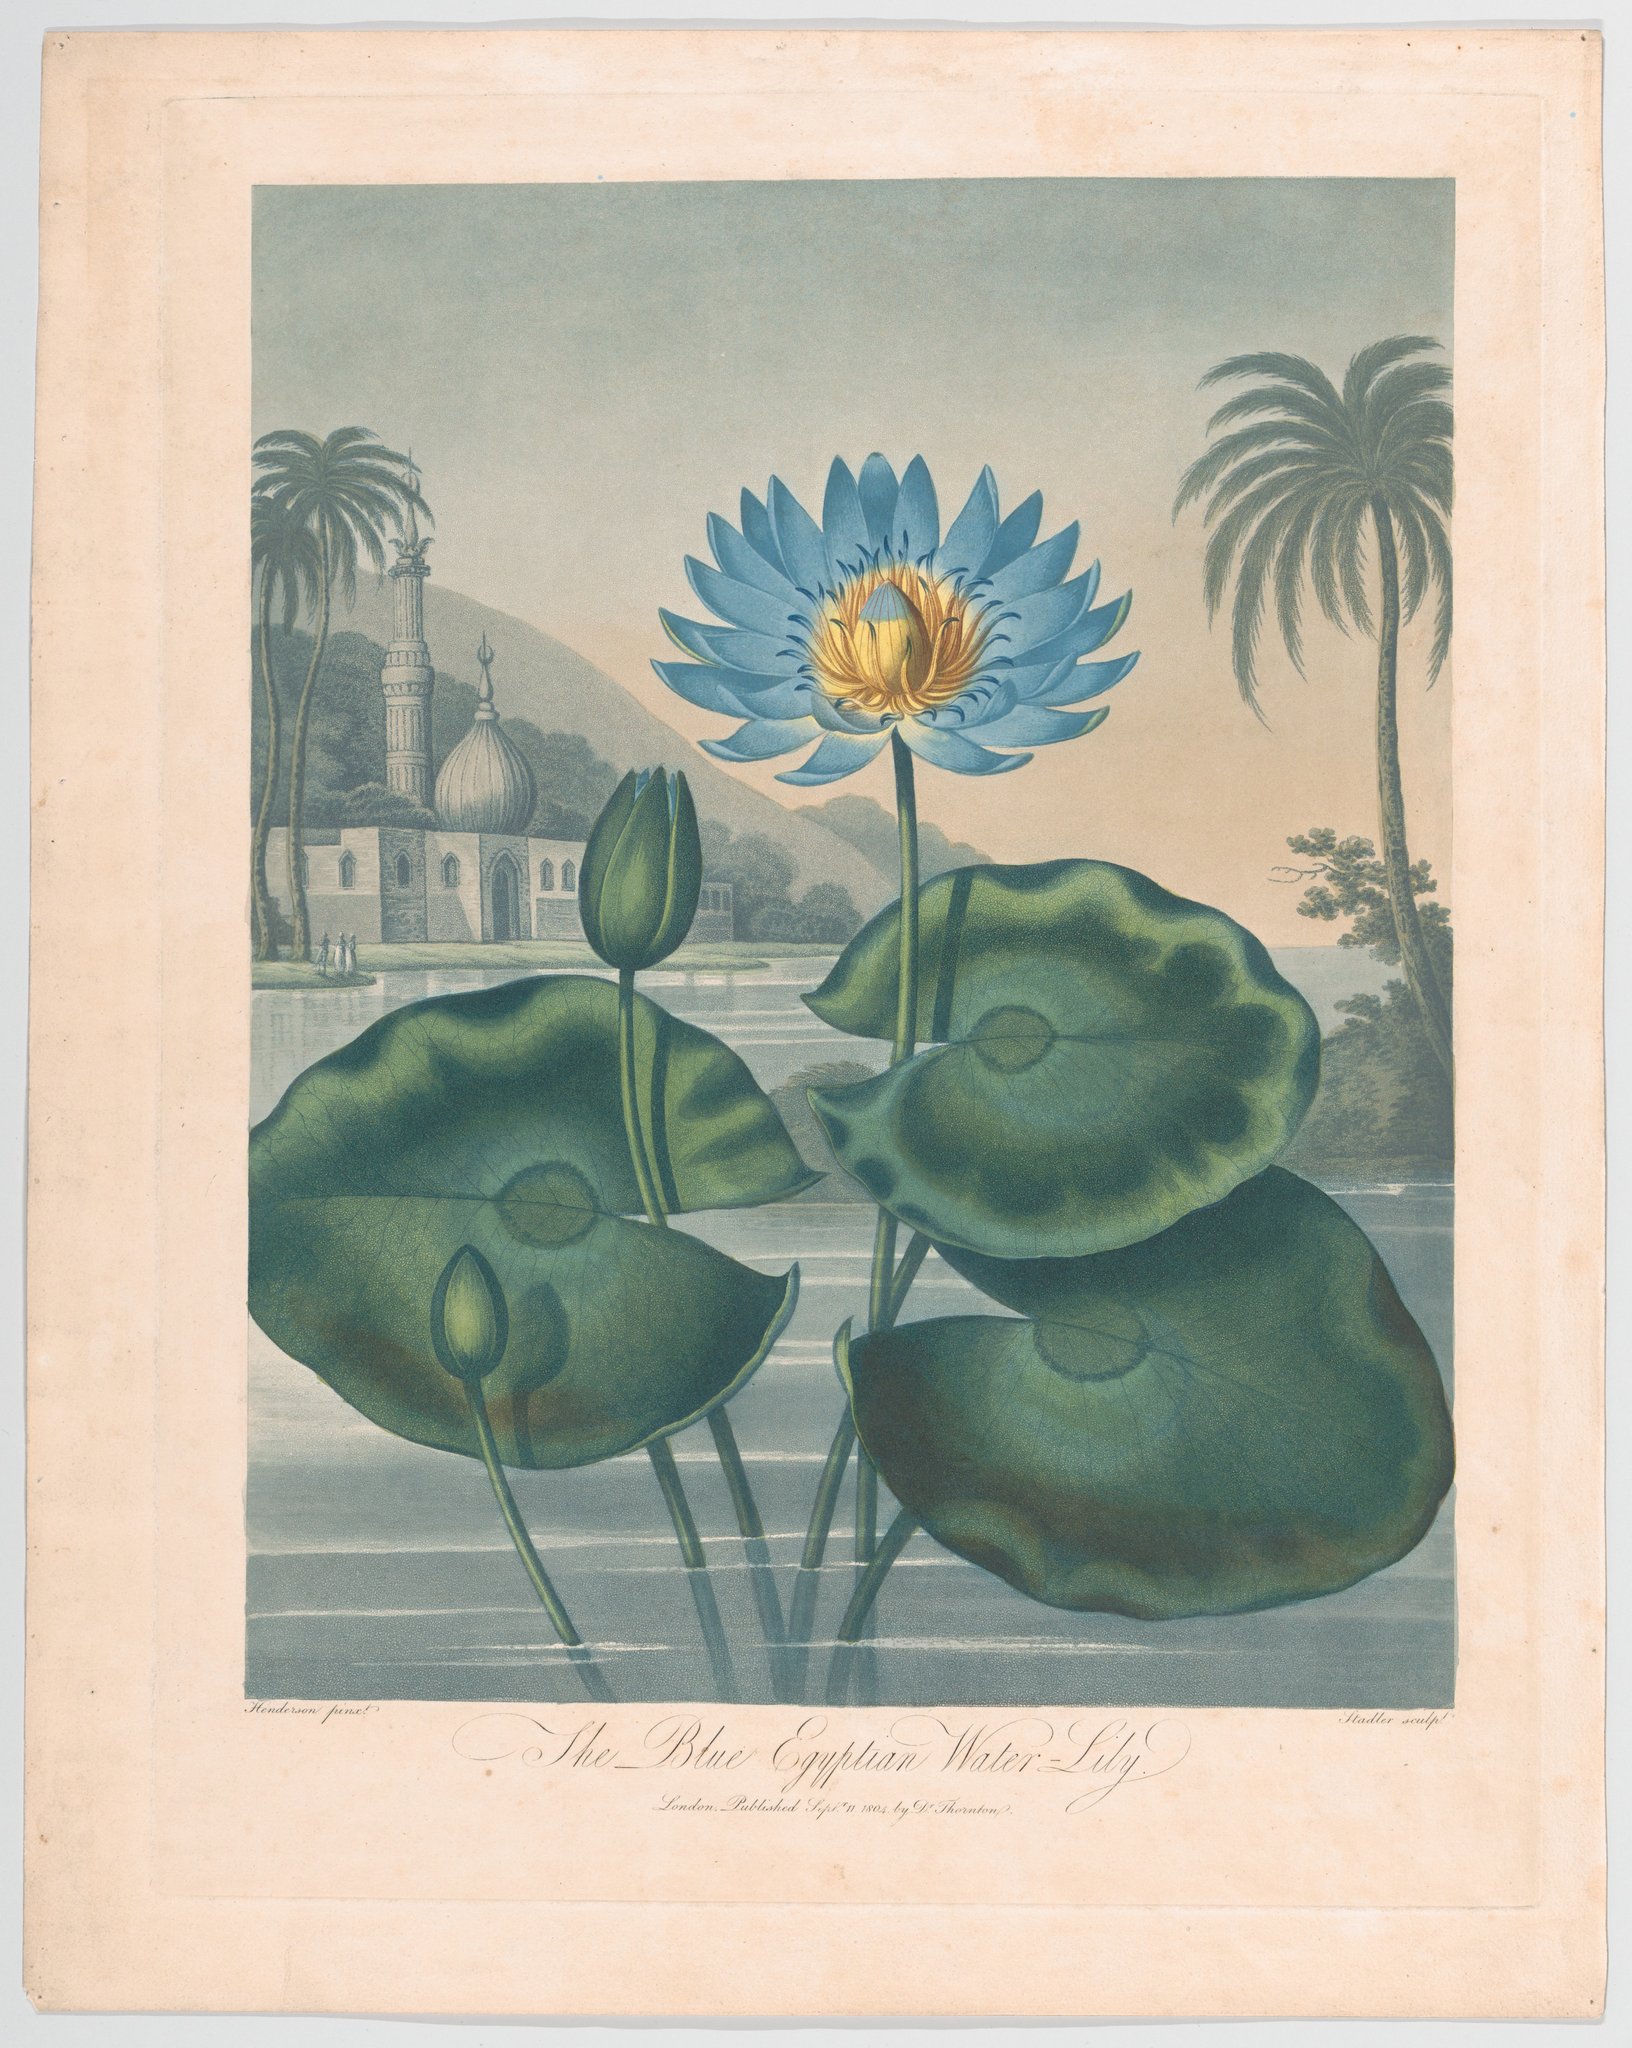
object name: print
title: The Blue Egyptian Water Lily, from "The Temple of Flora, or Garden of Nature"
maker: joseph constantine stadler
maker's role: engraver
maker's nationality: german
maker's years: 1780-1822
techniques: aquatint, hand coloring, printing, engraving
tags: buildings,leaves,trees,water lilies